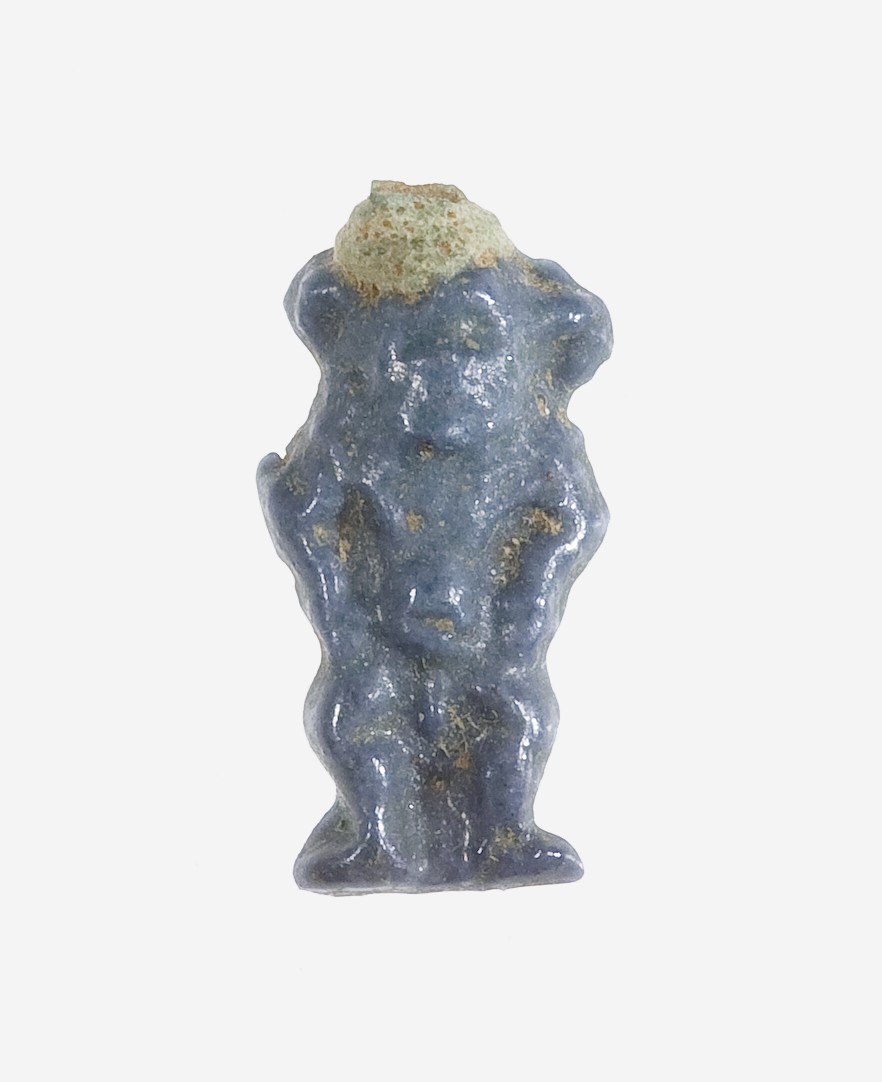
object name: amulet, be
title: Bes Amulet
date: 1390-1352 BCE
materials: faience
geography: egypt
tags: bes